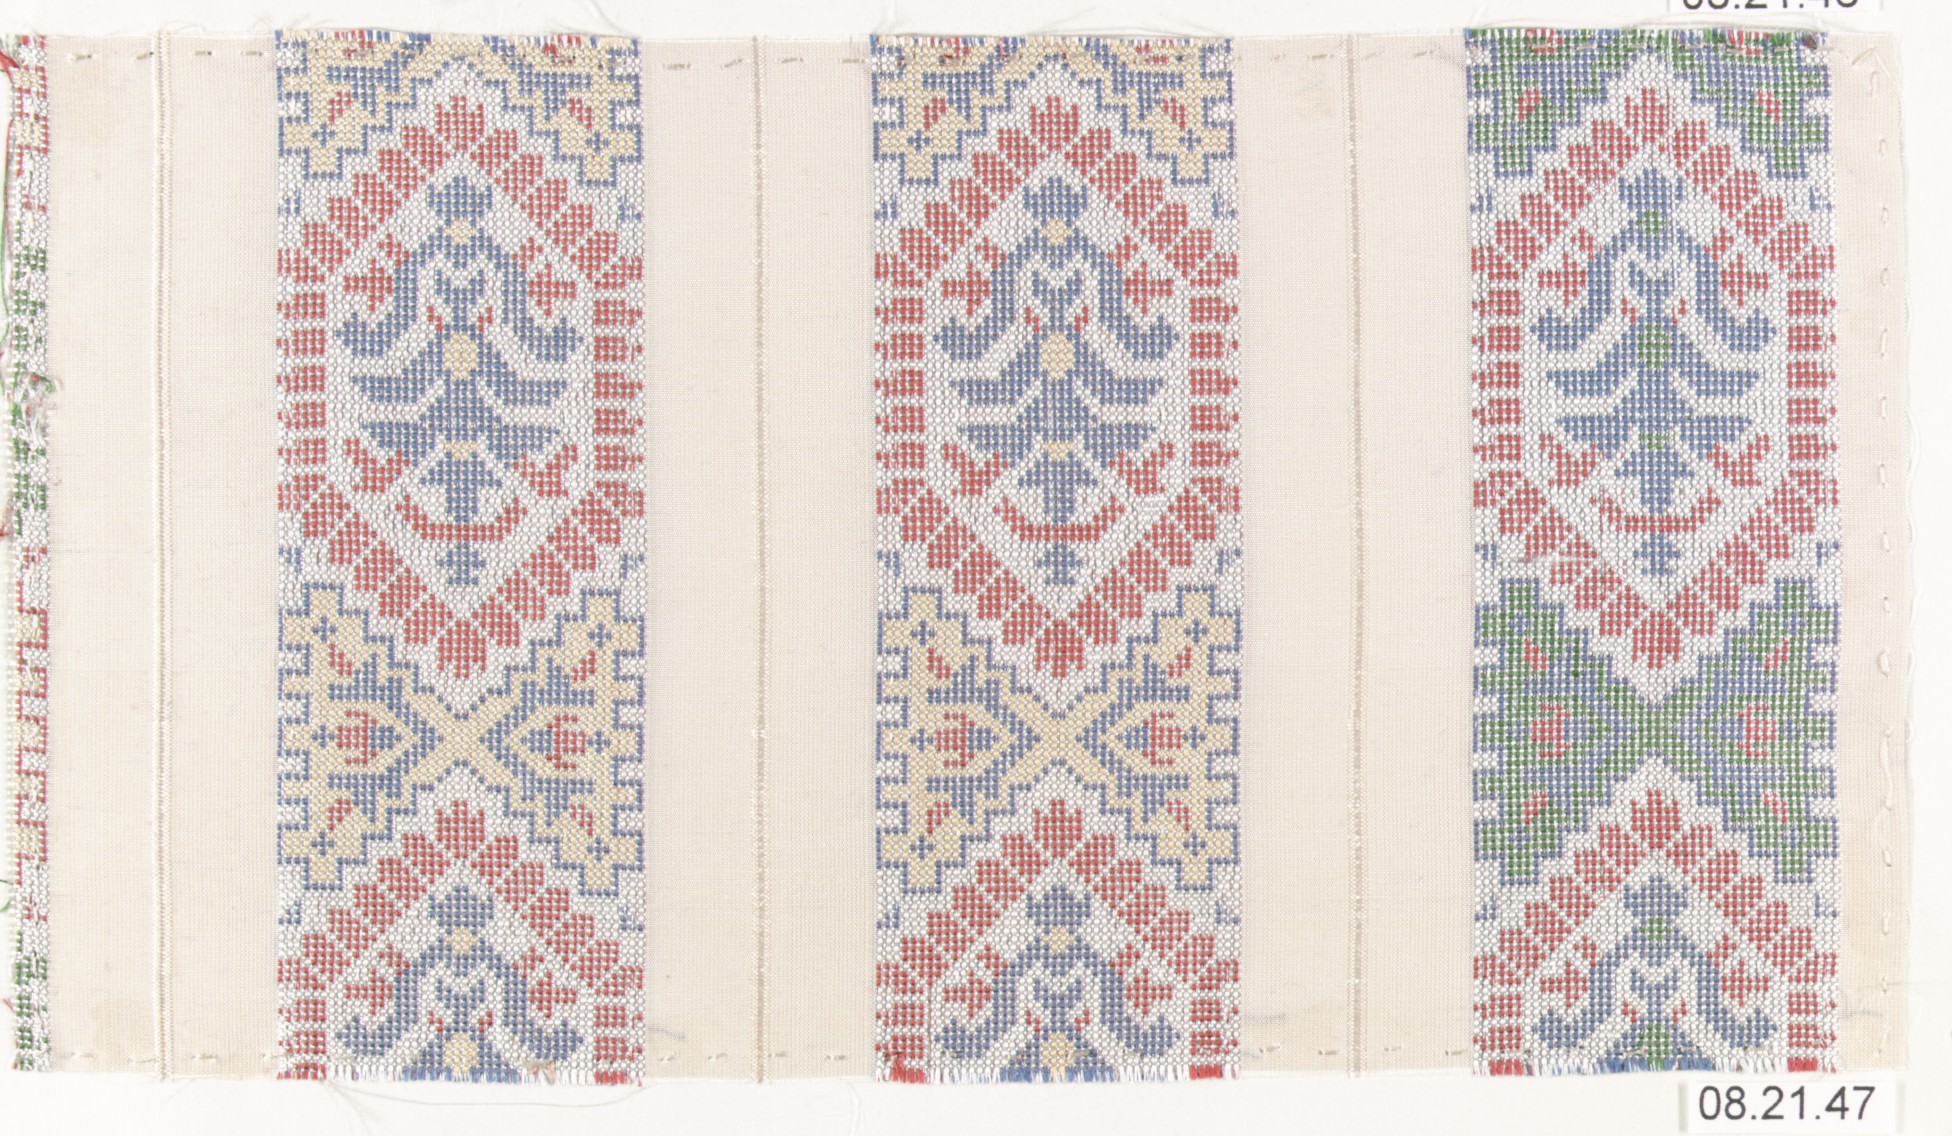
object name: textile sample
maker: Anonymous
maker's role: designer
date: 1900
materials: silk